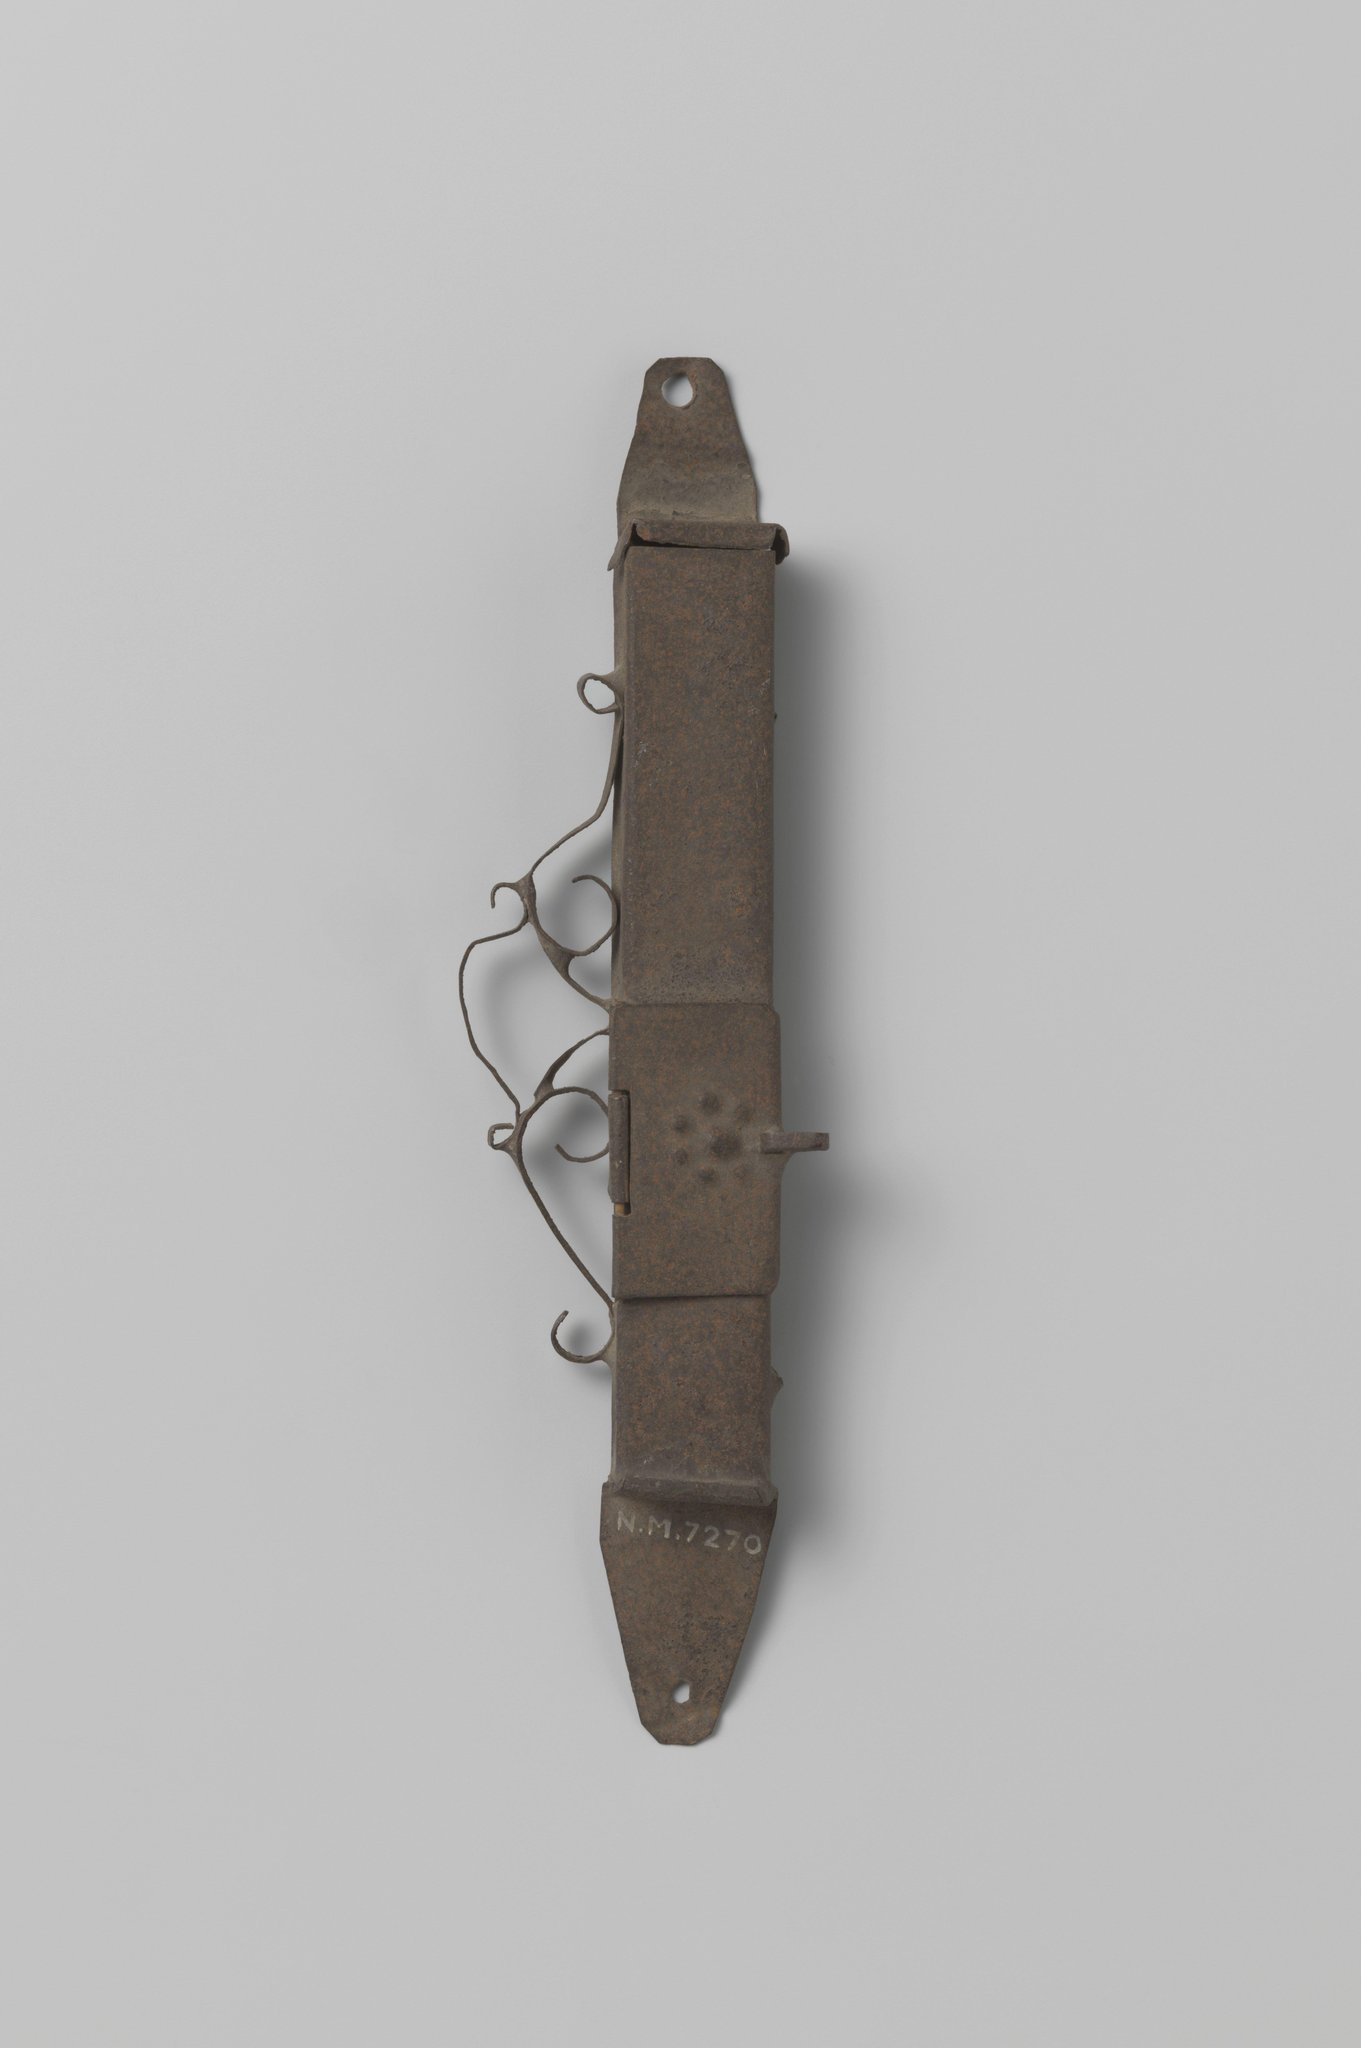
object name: mezuzah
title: Mezoeza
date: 1400-1950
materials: iron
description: De Joodse wet in een ijzeren foedraal, zoals dit aan de deuren der Israelieten gehangen wordt.